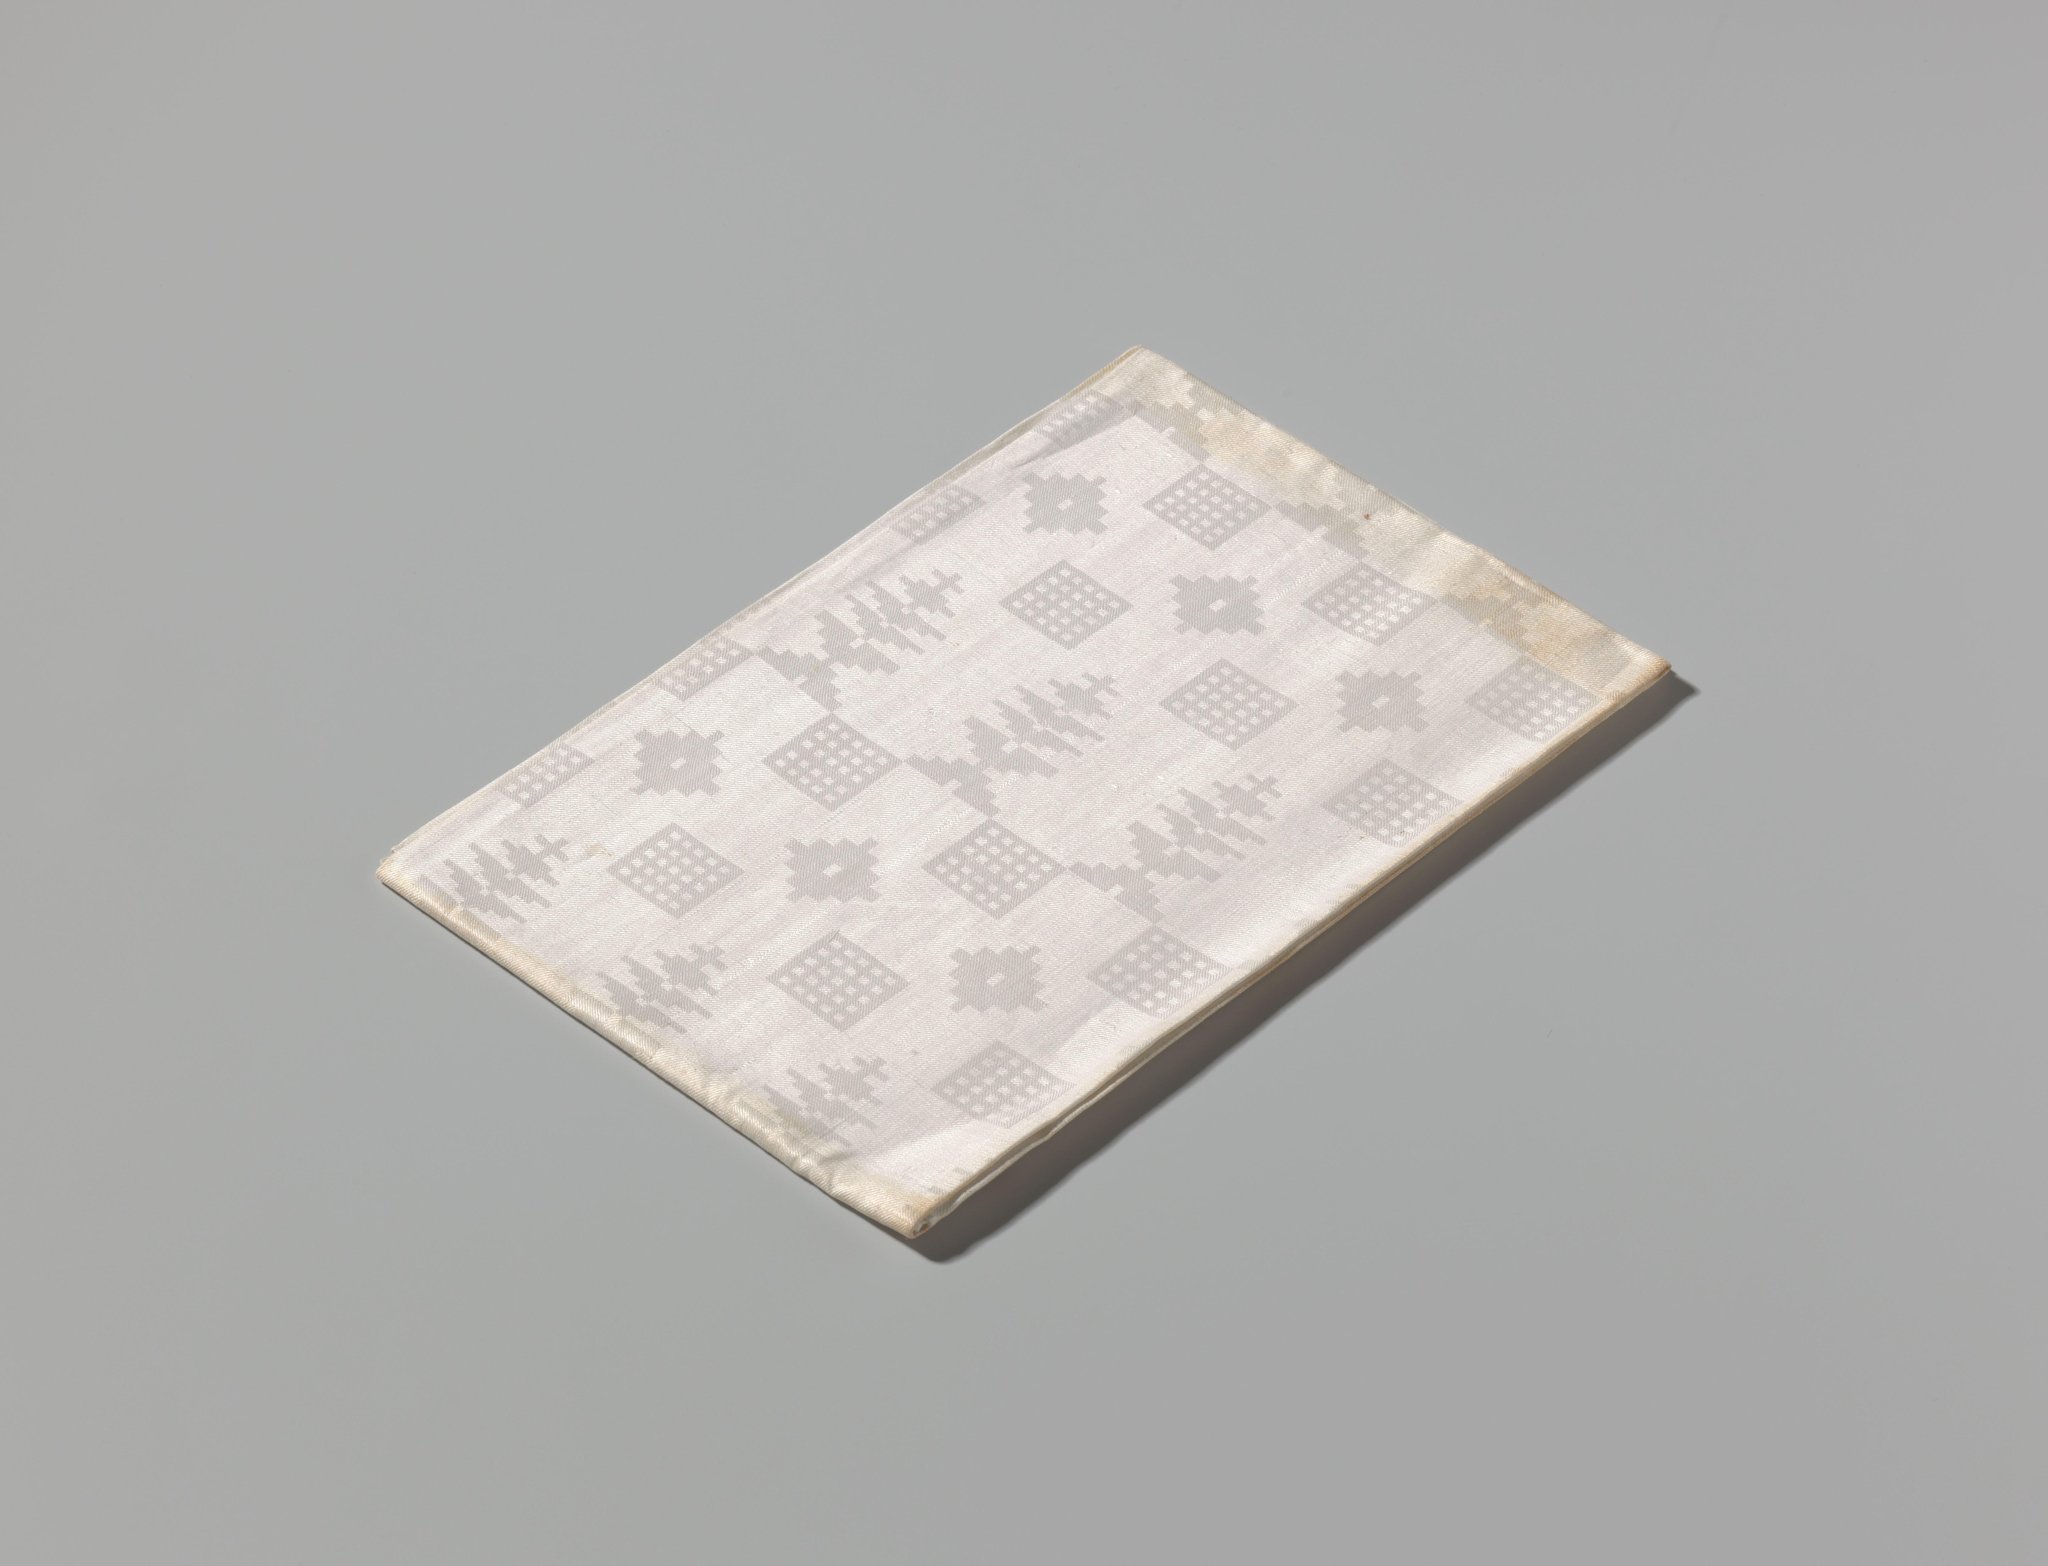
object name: towel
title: Handdwaal van wit linnen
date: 1730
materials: linen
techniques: peeled fabric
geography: northern netherlands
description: Wit linnen handdwaal met pellen patroon in keperbinding. Merk kroon WG 2 en 1730.